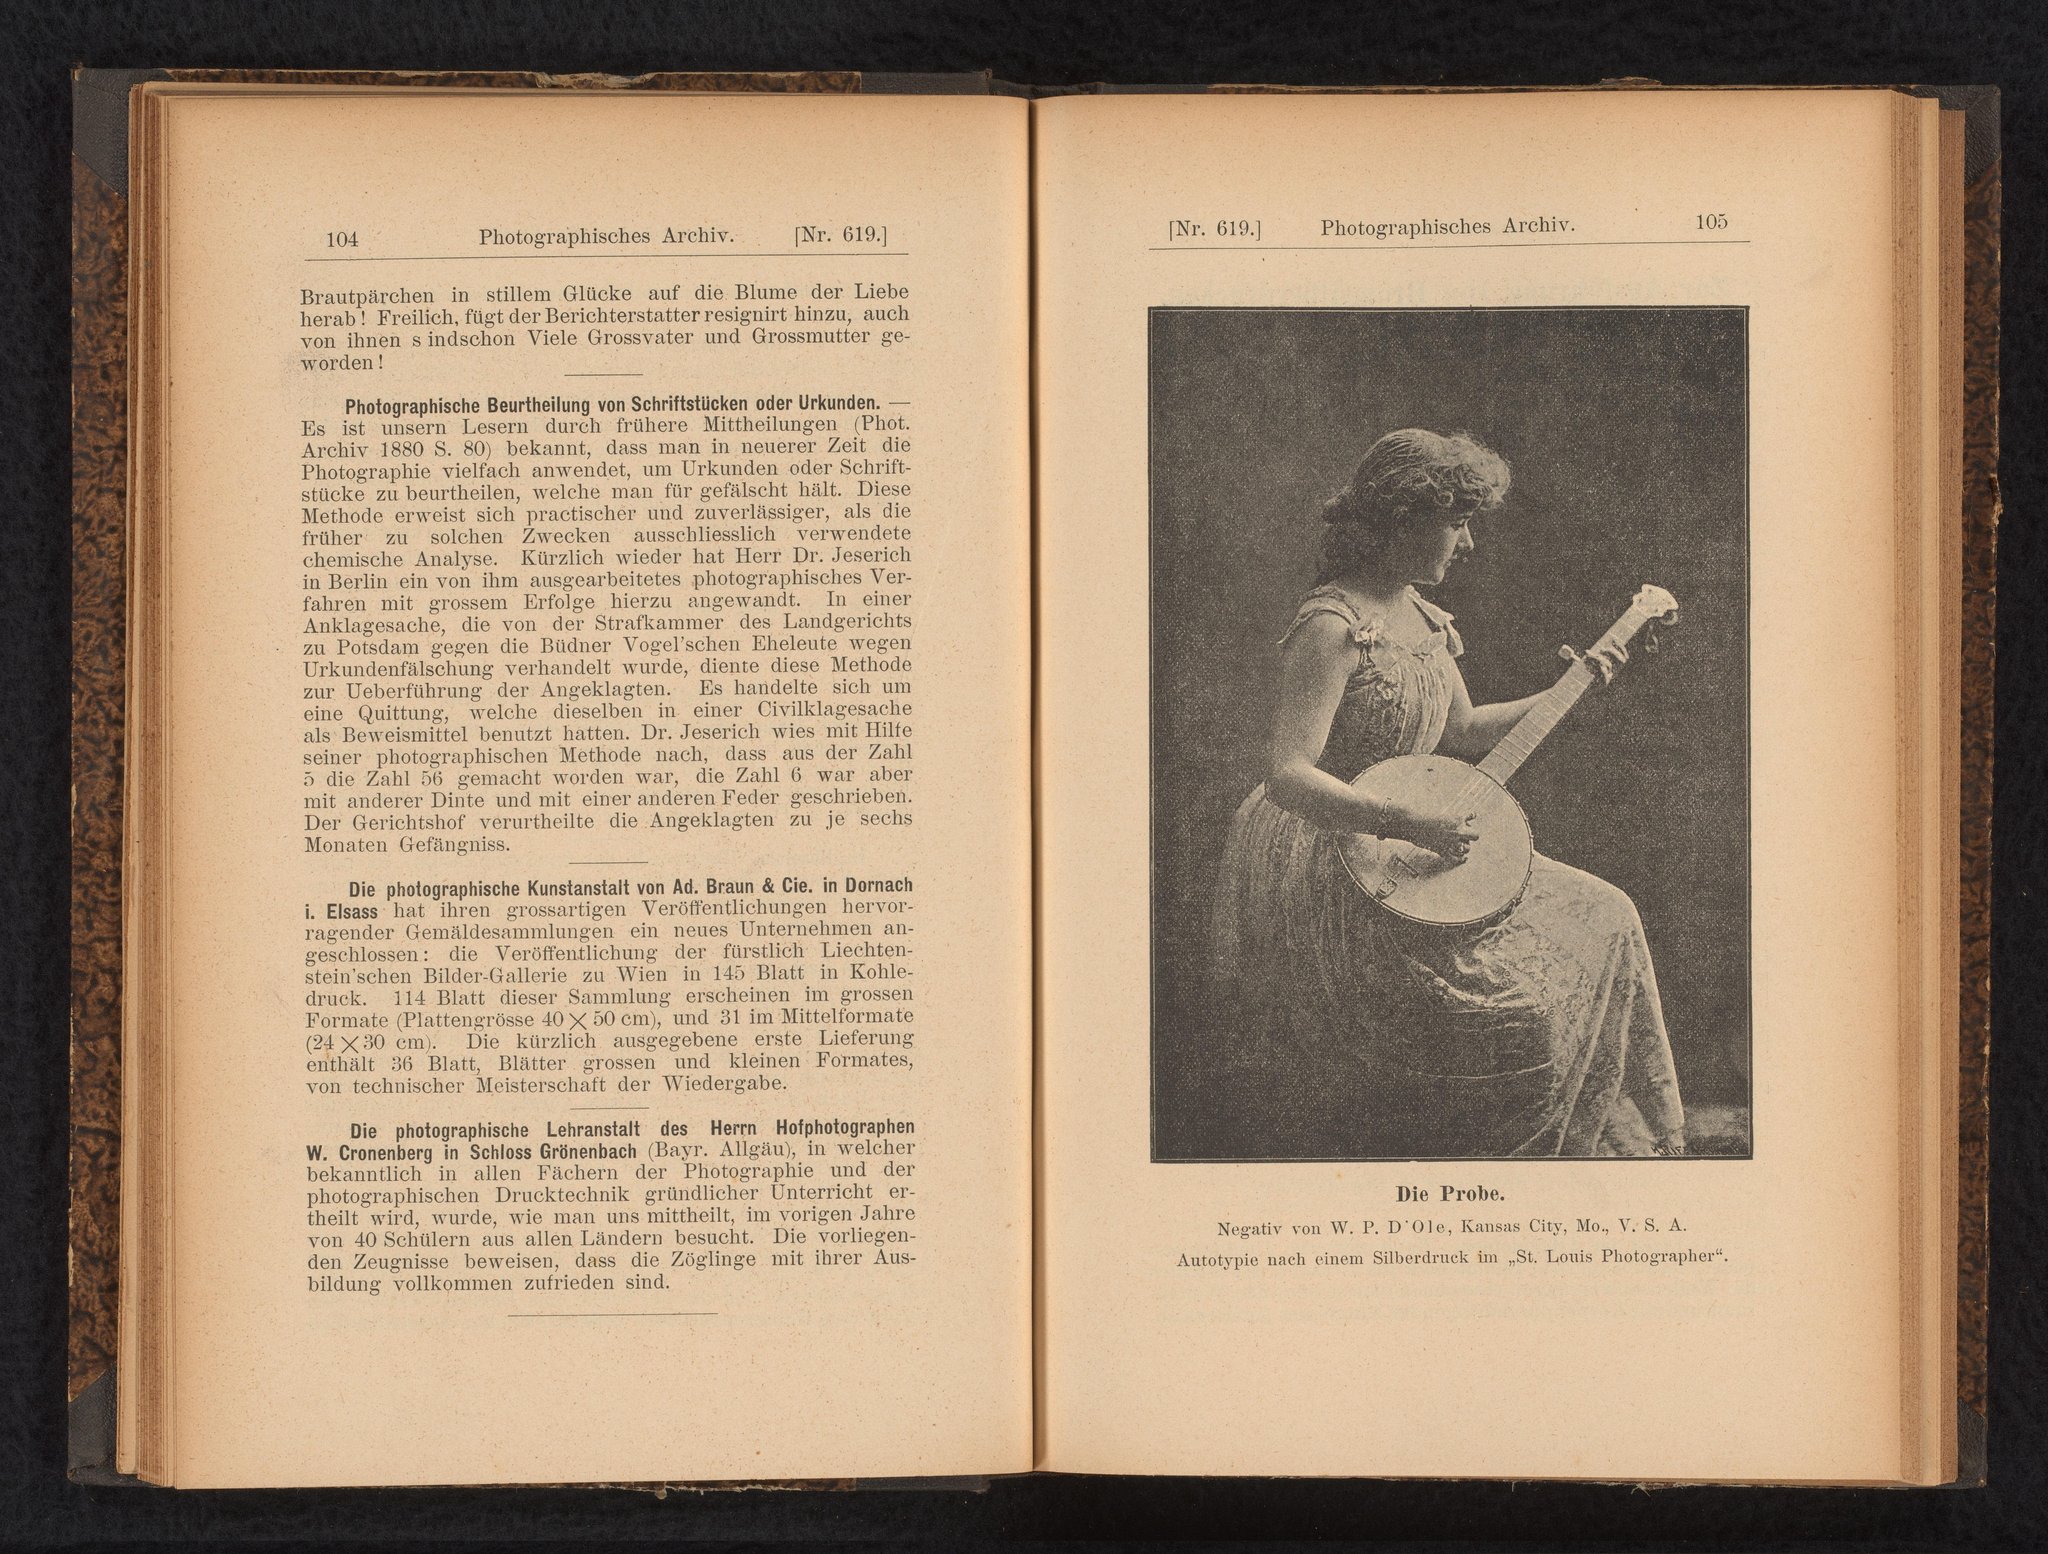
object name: page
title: Portret van een onbekende vrouw met een banjo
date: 1884-1889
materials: paper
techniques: autotype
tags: historical persons not known by name - bb - woman, one person playing an instrument, cithern, mandolin, guitar, balalaika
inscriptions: signature: ‘H. Riffarth’, inscription: ‘Negativ von W.P. D'Ole, Kansas City, Mo., V.S.A./ Autotypie nach einem Silberdruck im "St. Louis Photographer".’